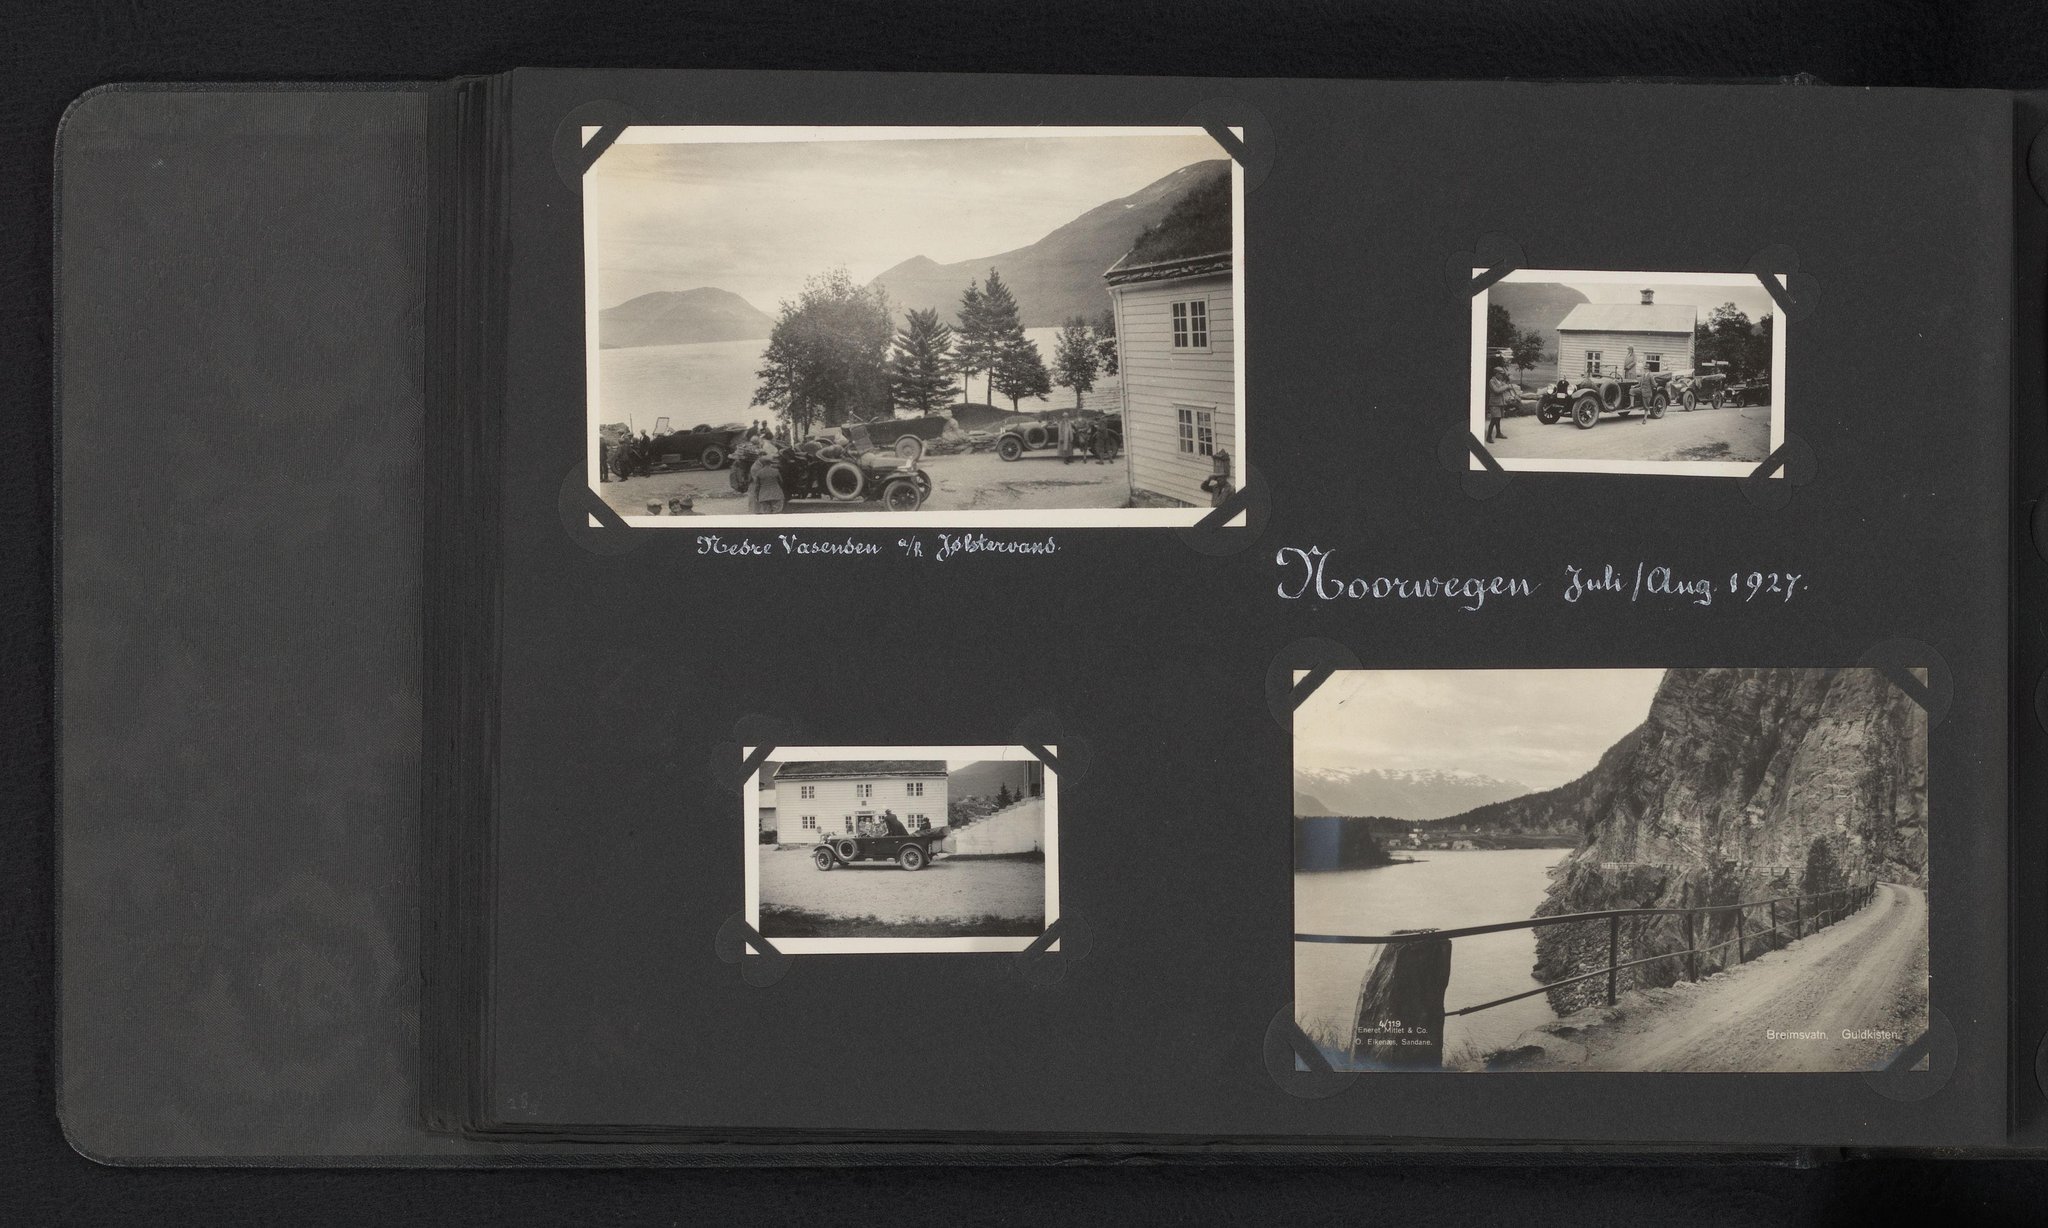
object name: album leaf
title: Noorwegen Juli/Aug. 1927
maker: hendrik herman van den berg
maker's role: amateurfotograaf, jurist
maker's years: 1875-1944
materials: paper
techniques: gelatin silver print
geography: norway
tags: lake, automobile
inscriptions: inscription: ‘Nedre Vasenden a/h Jølstervand’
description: Deze foto's maken deel uit van een album.